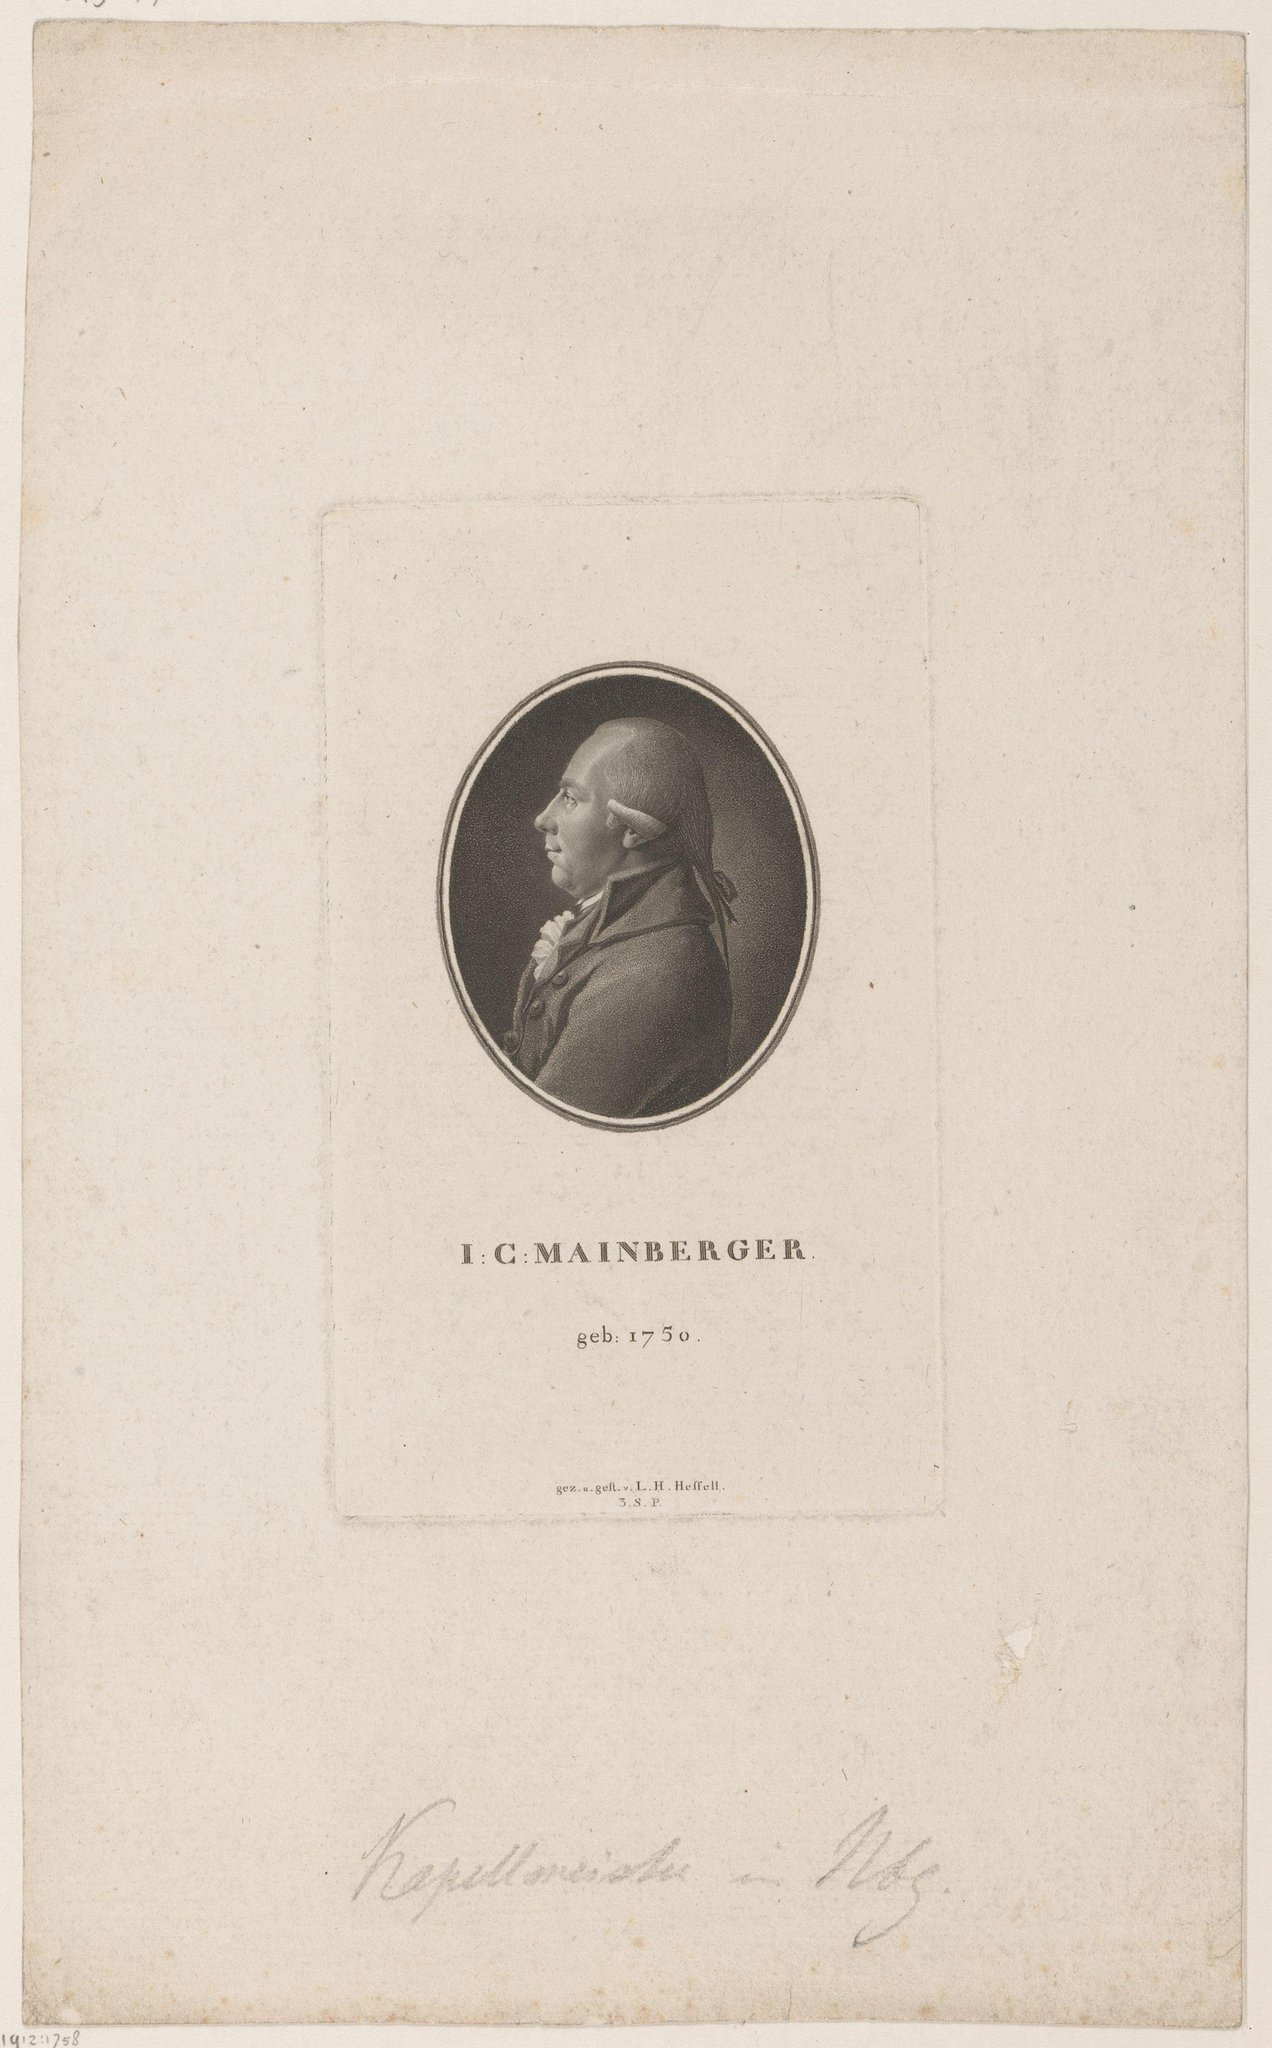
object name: print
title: Portret van Johann Christoph Mainberger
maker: leonhard heinrich hessell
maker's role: musical instrument maker, painter, print maker, publisher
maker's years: 1757-1830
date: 1767-1850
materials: paper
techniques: aquatint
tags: historical persons, portrait of composer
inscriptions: collector's mark: Lugt 2228